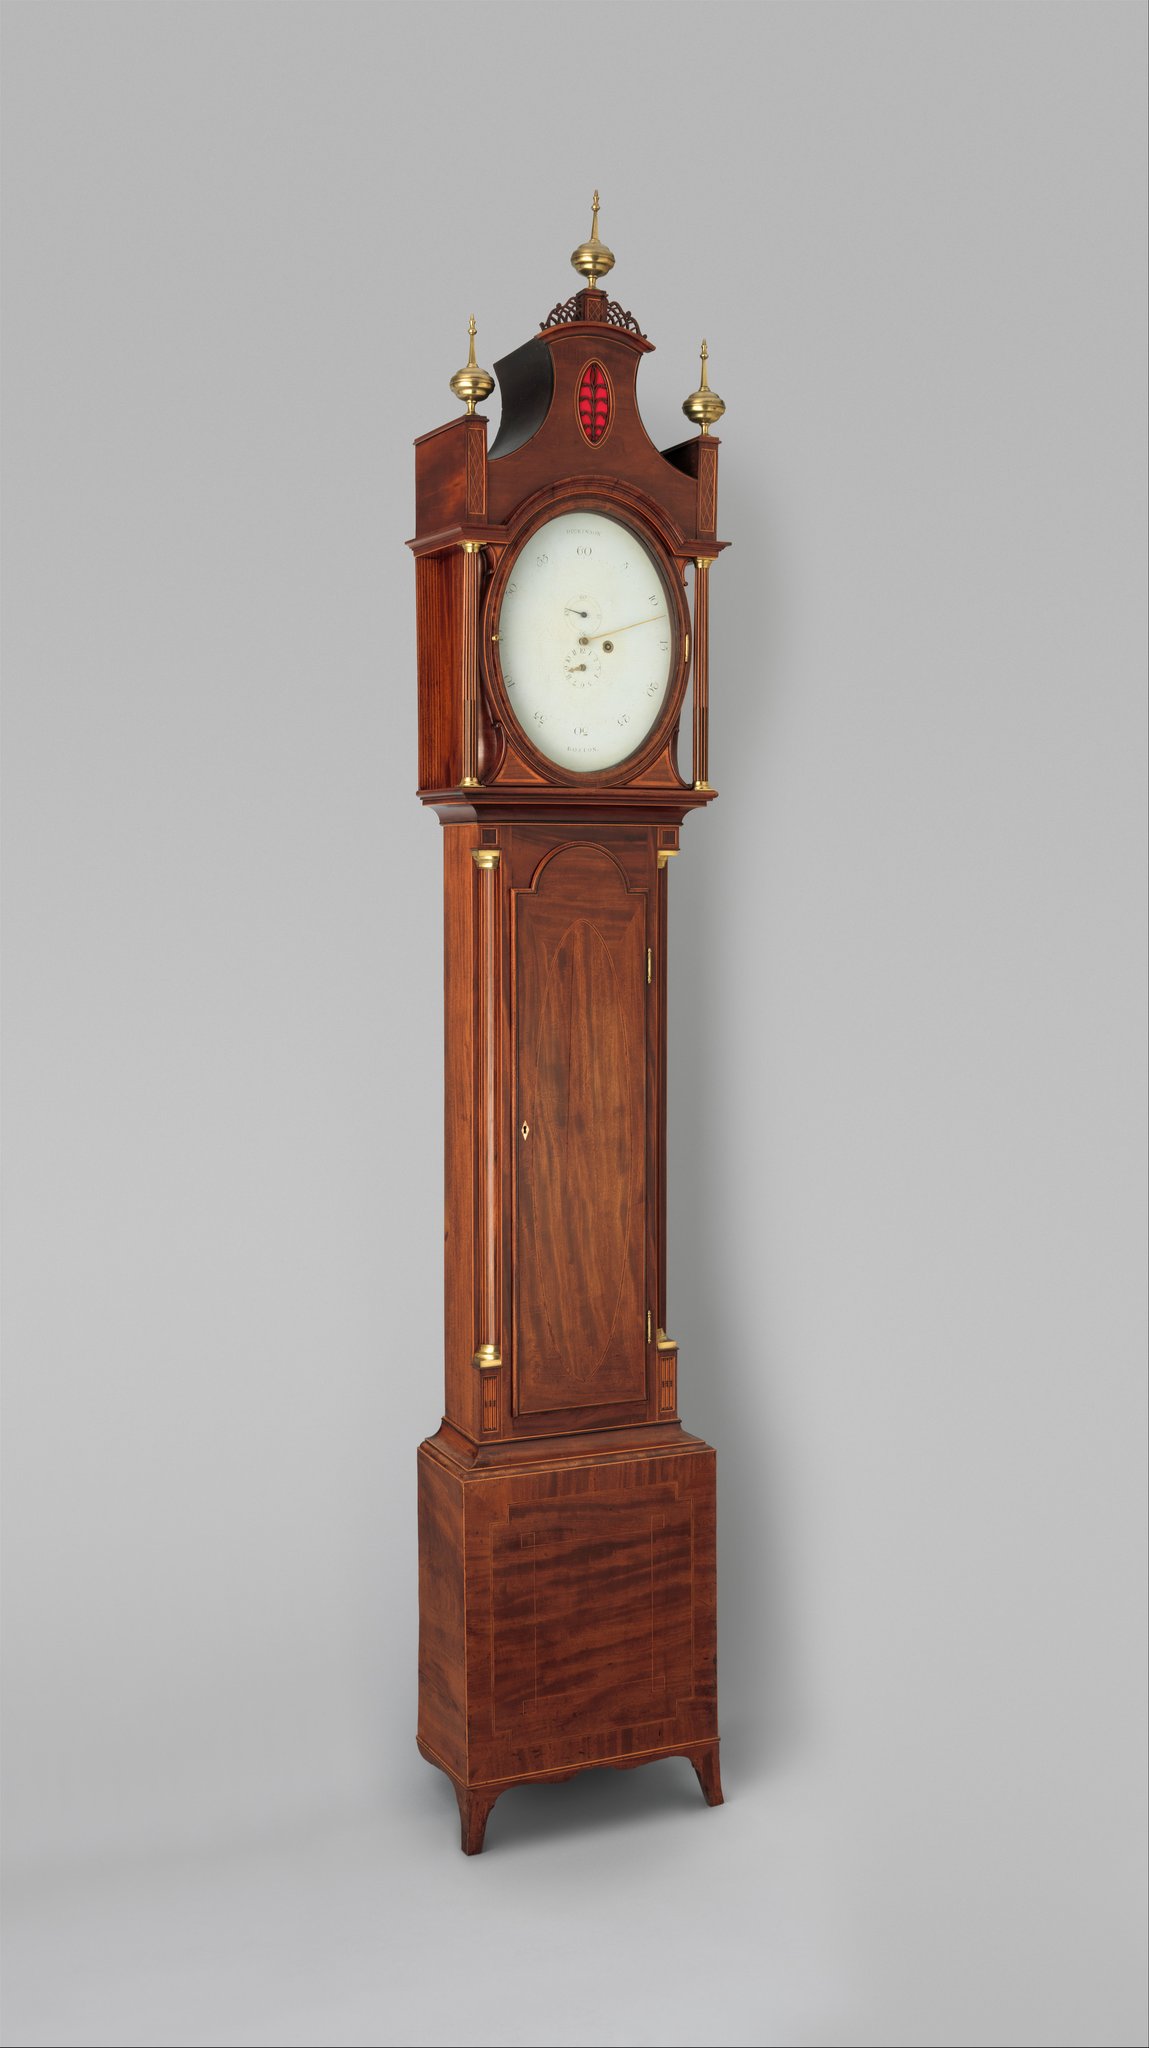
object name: longcase clock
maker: thomas dickenson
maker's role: maker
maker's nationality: british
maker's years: 1790-1827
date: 1807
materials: bone, brass, copper, enamel, wood, steel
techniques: inlay, painting, stain, veneering